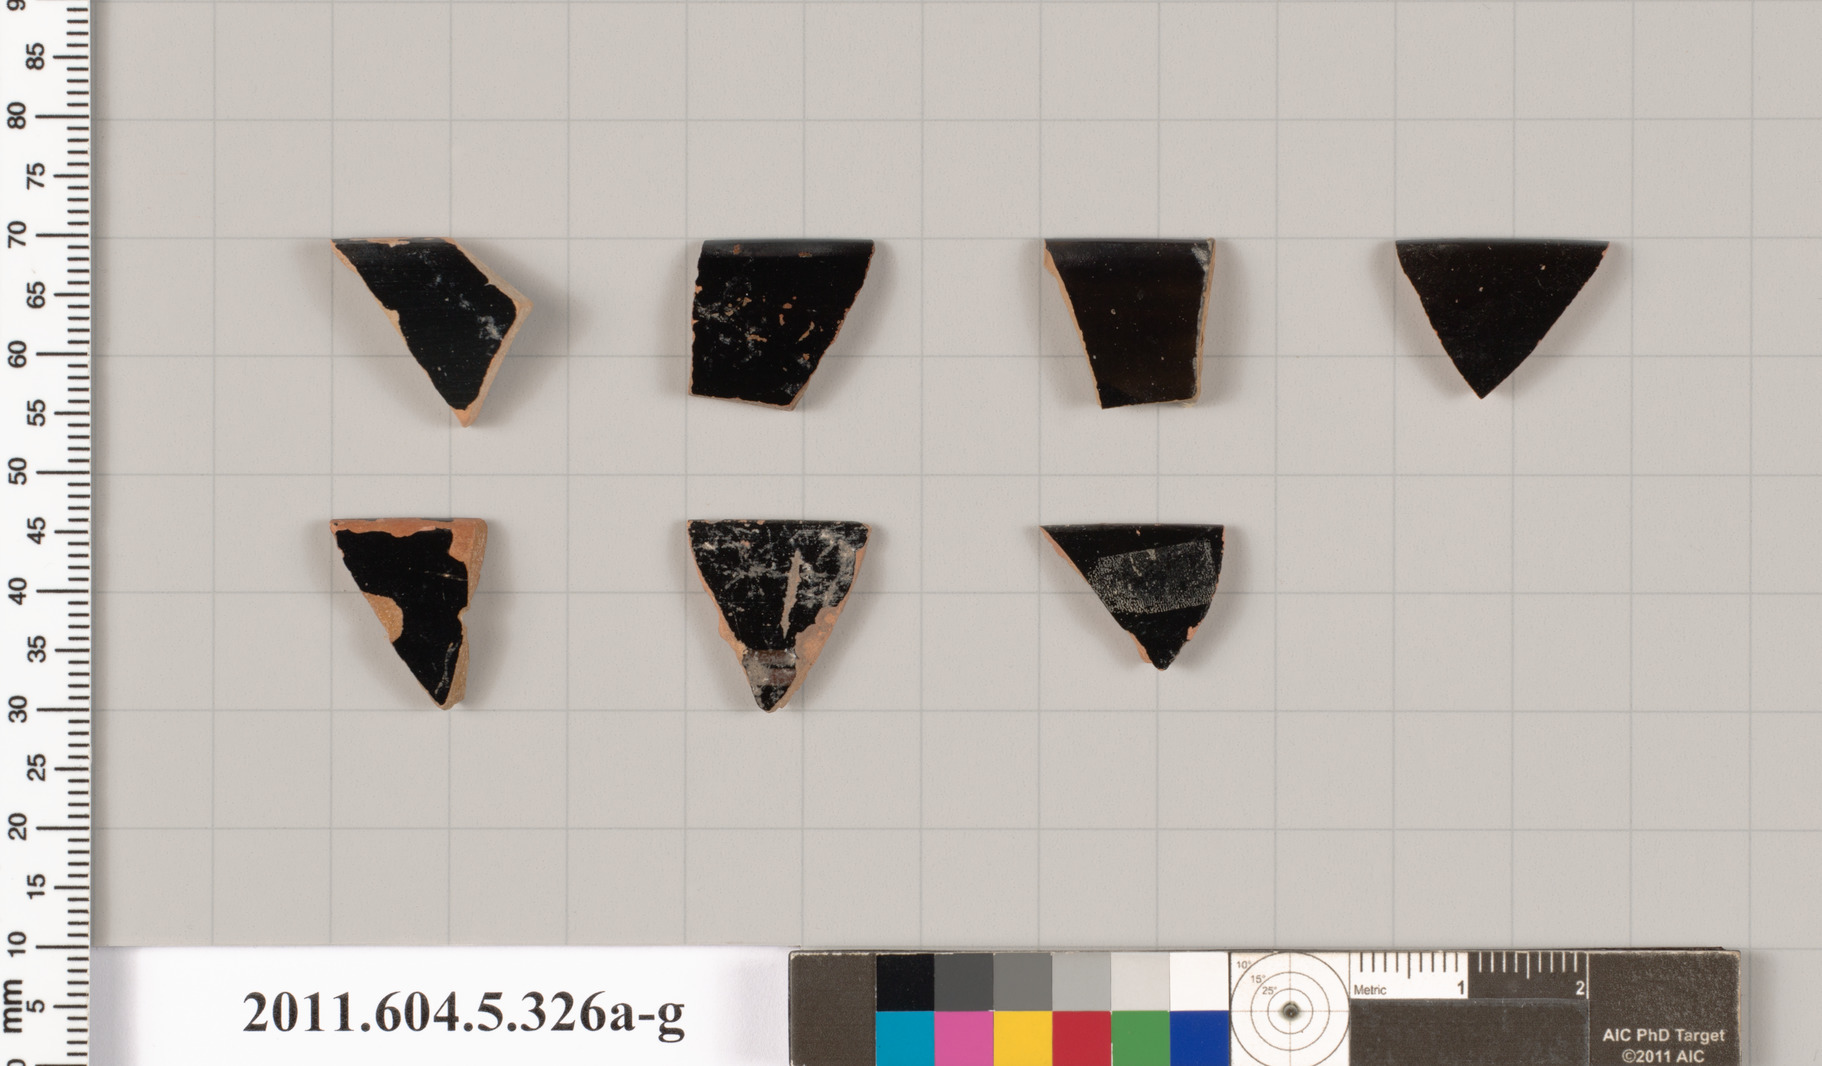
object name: kylix fragment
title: Terracotta rim fragments of kylikes (drinking cups)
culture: greek, attic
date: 600-401 BCE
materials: terracotta